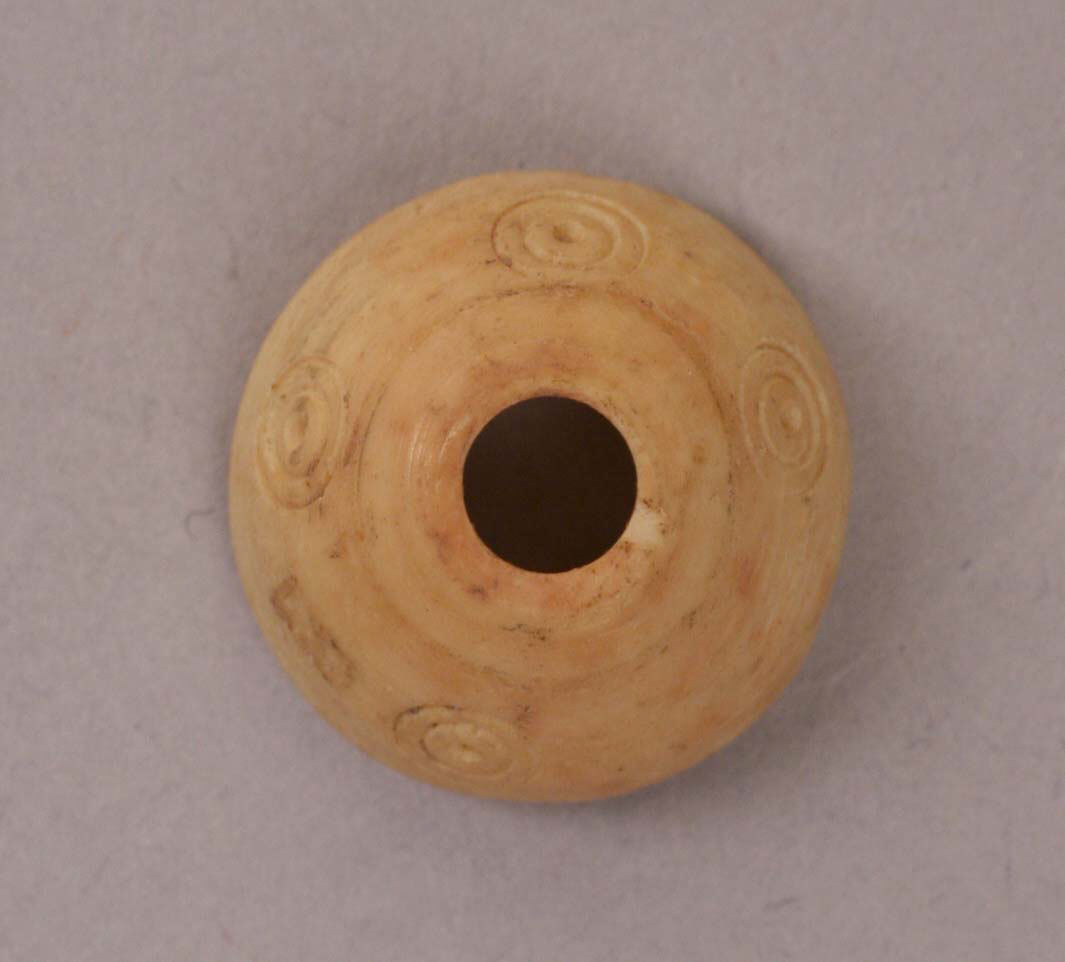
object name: button or bead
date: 801-1000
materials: bone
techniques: incising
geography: iran